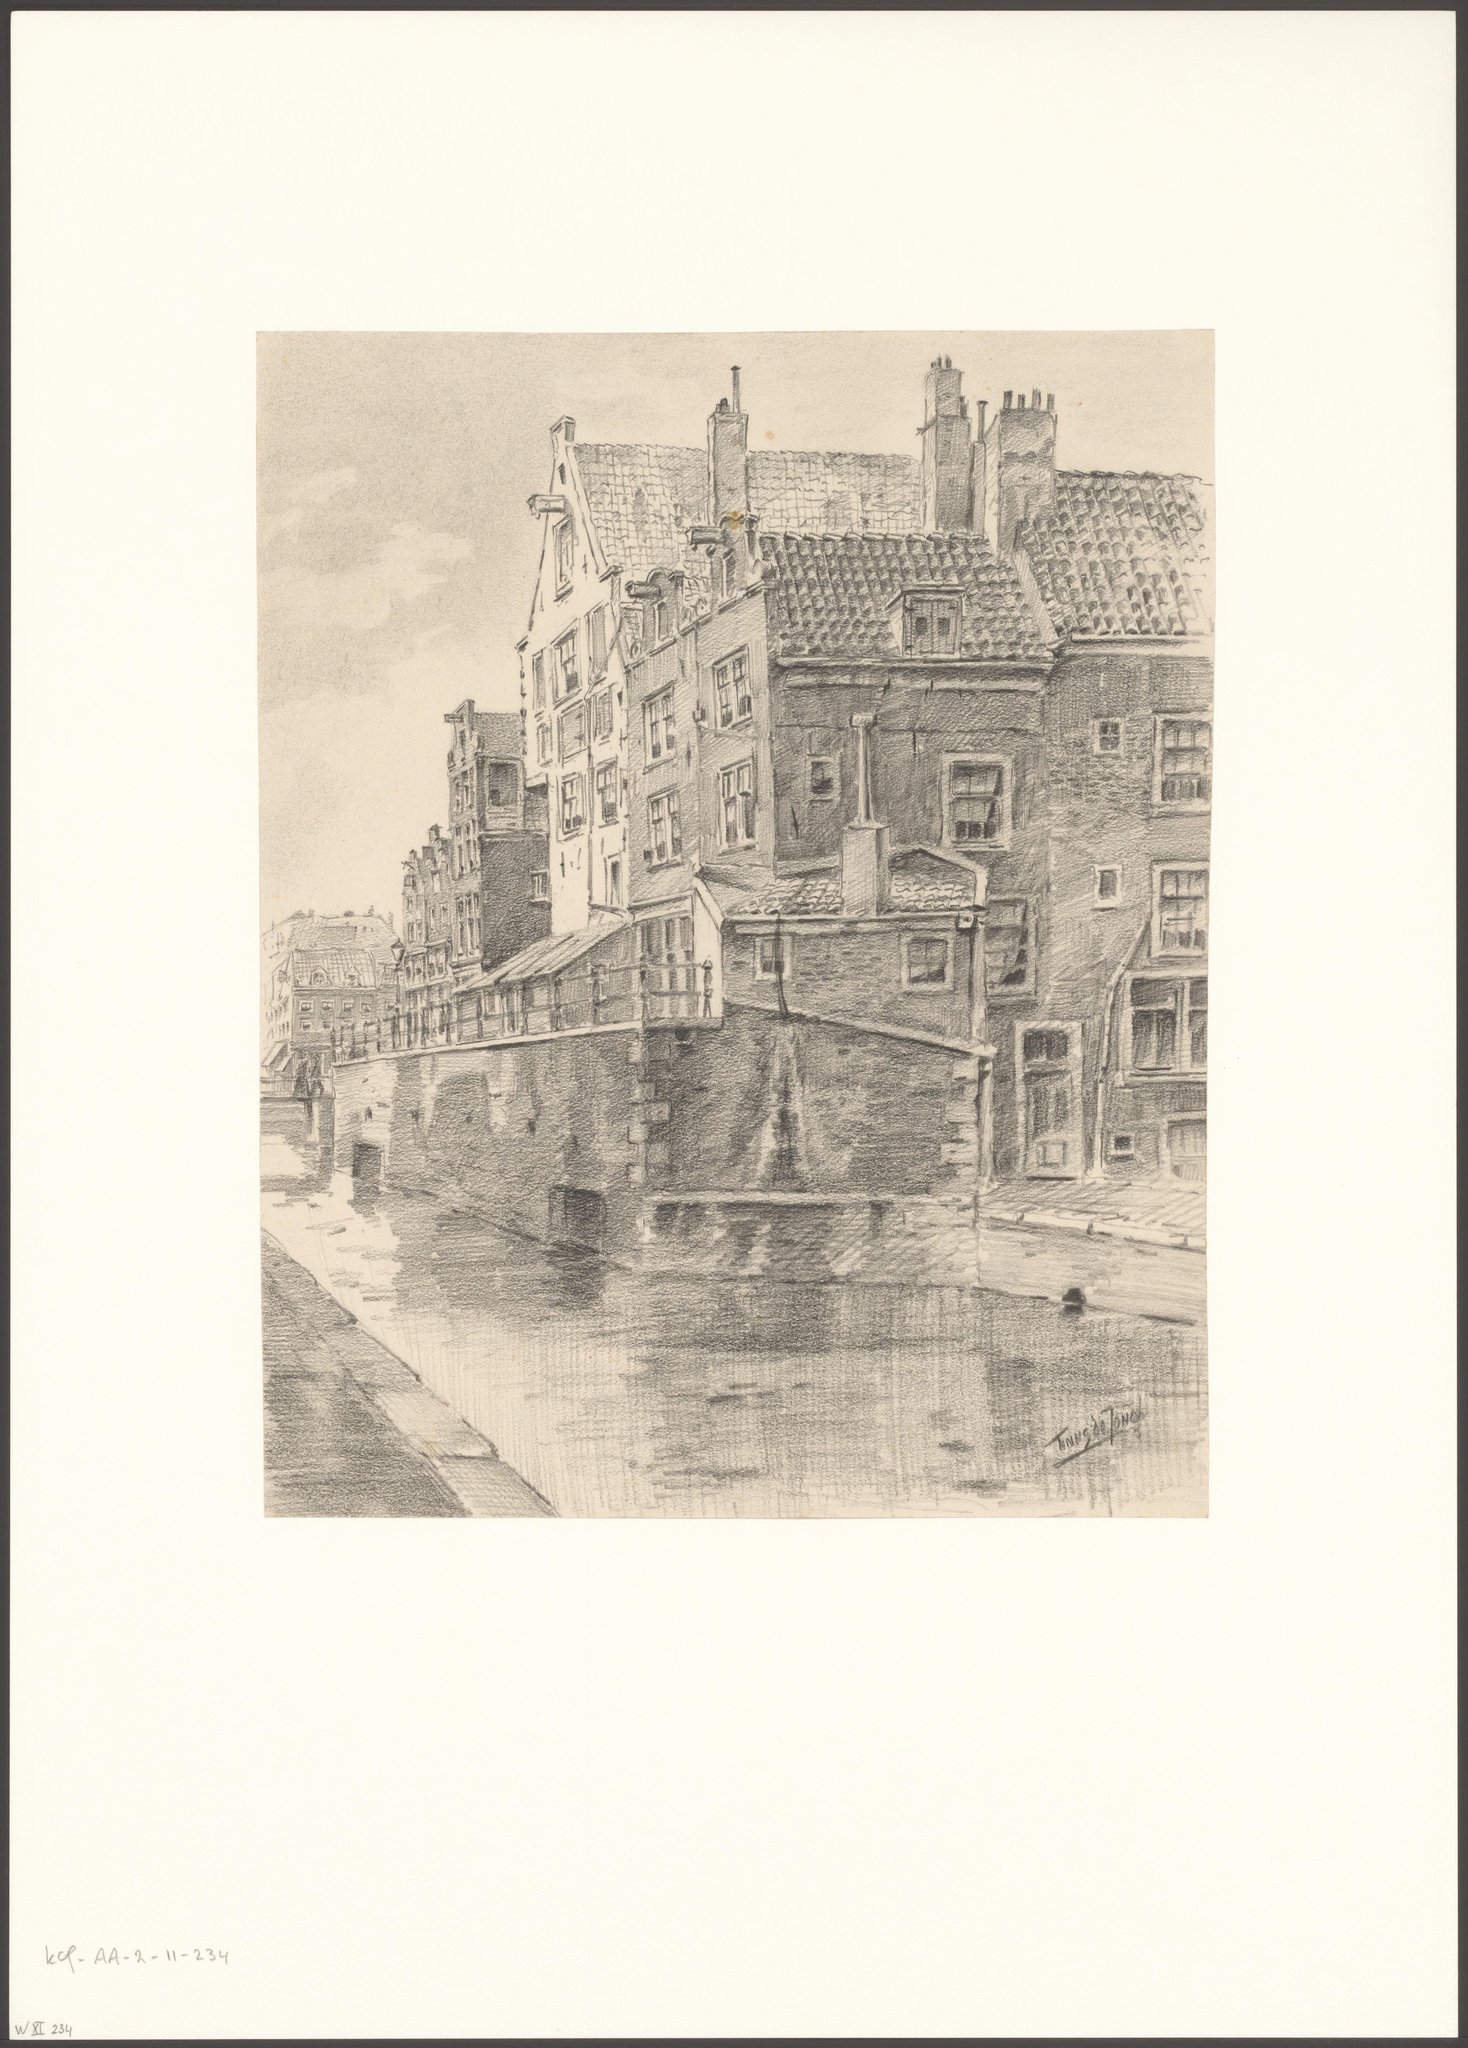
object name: drawing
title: Gezicht op de Grimburgwal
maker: tinus de jongh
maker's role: print maker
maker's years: 1885-1942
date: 1895-1942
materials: chalk, paper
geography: amsterdam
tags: city-view in general; 'veduta', canal, façade (of house or building)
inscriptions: signature: ‘Tinus de Jongh’, collector's mark: Lugt 800a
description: Tekening binnen de Atlas Van Eck ingedeeld op wijknummer 11.